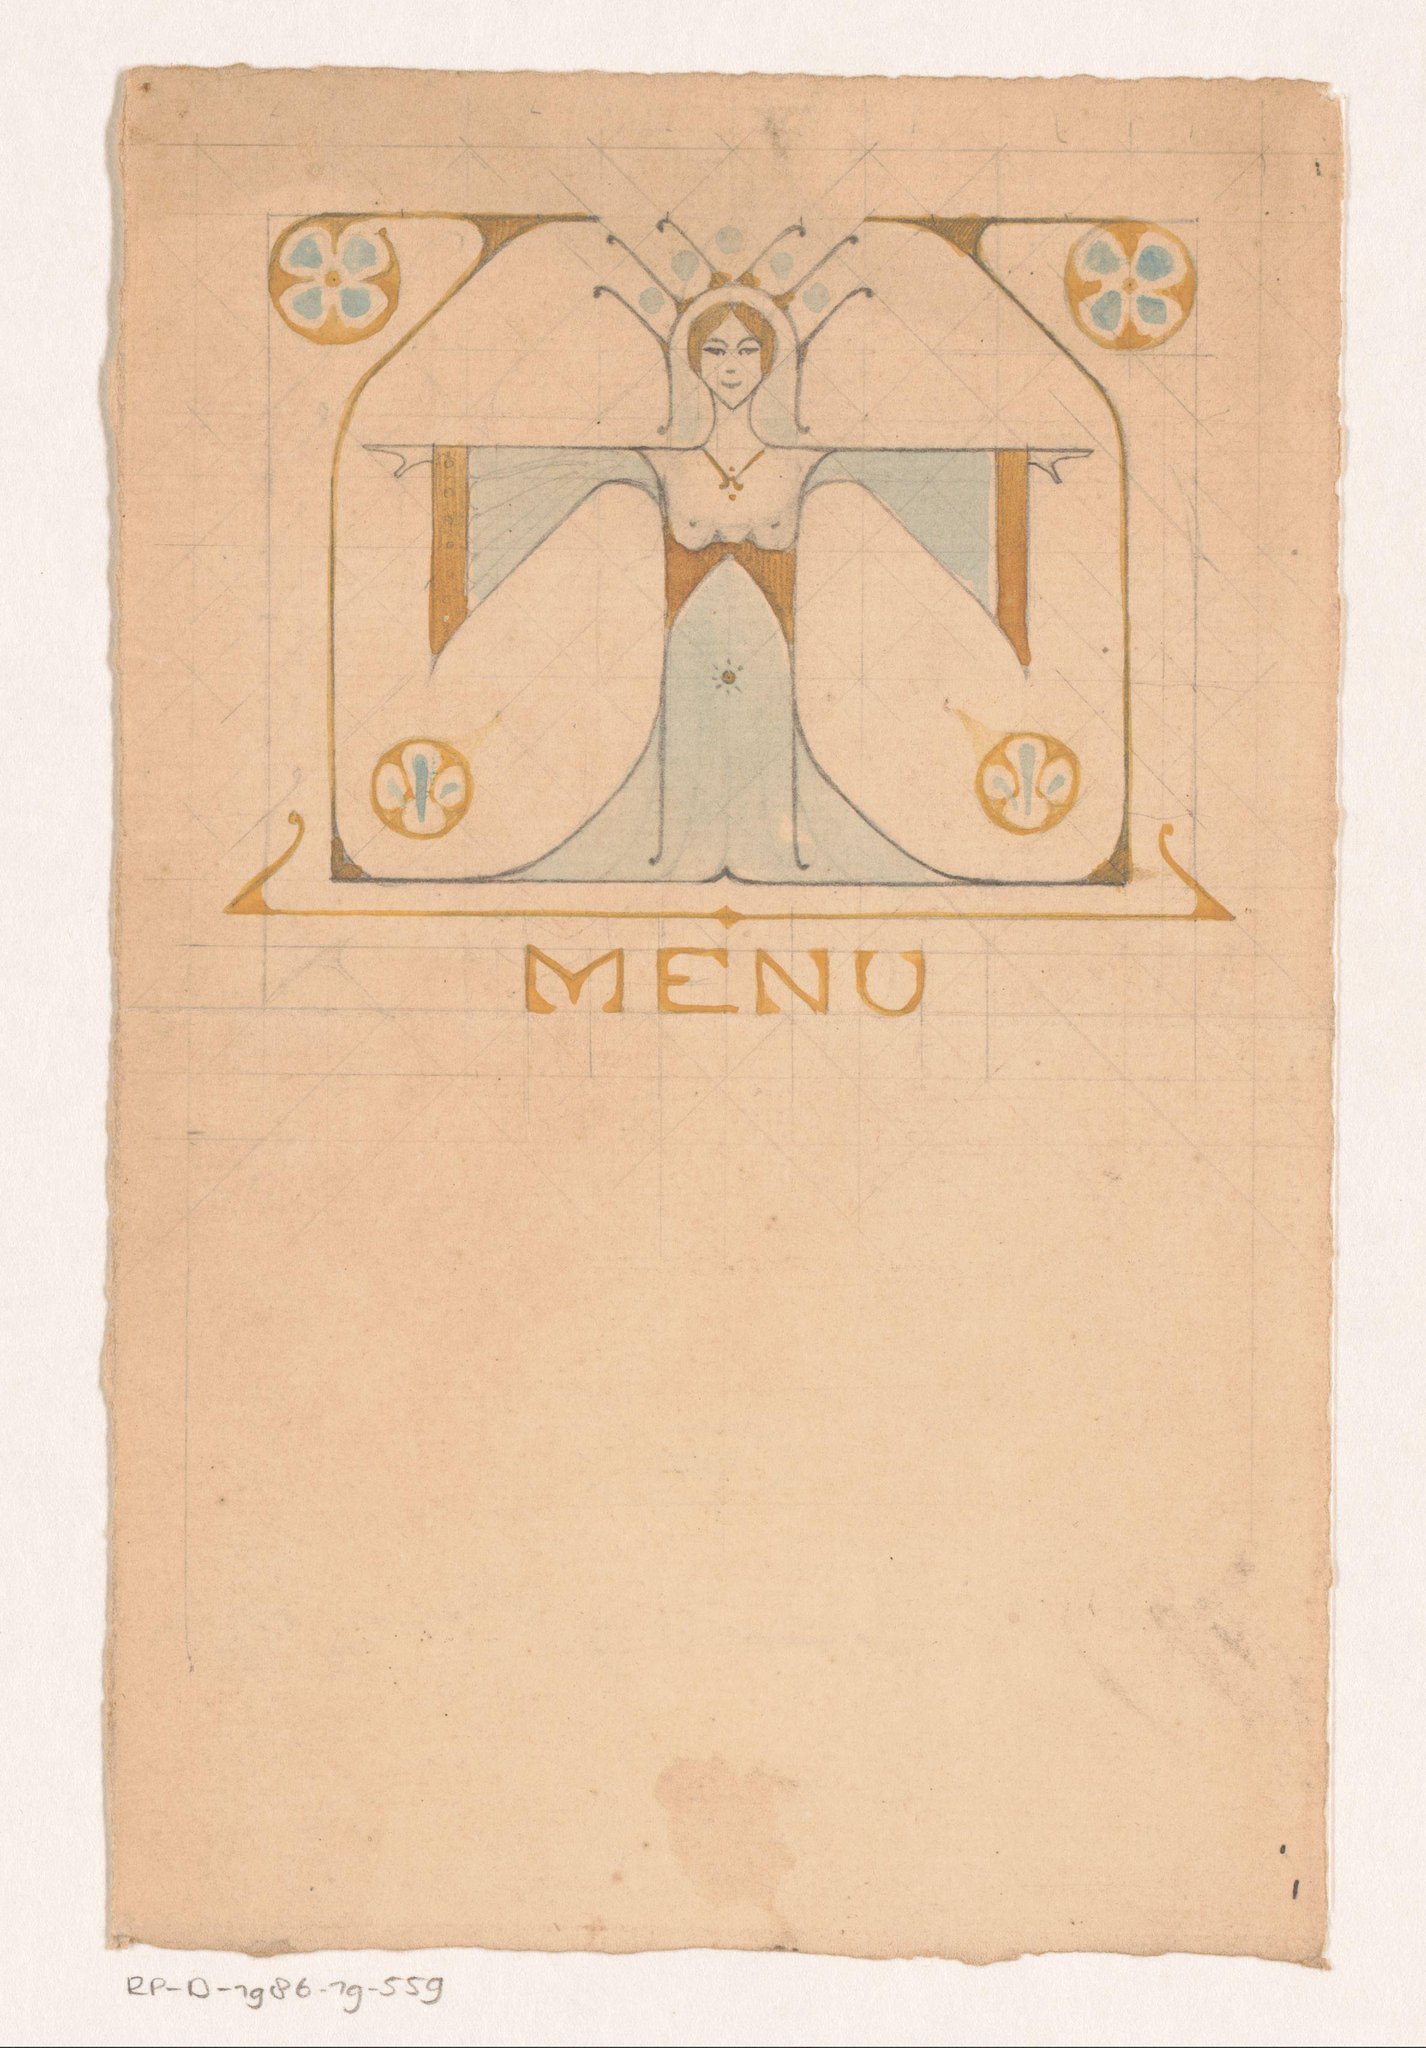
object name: drawing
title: Ontwerp voor een menukaart met een halfnaakte vrouw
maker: reinier willem petrus de vries (1874-1953)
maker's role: draughtsman, print maker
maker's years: 1874-1953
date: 1884-1952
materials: paper, pencil, watercolor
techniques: brush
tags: partially clothed, arm stretched sidewards - aa - both arms or hands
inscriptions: collector's mark: ‘R:MVS.’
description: De vrouw strekt haar armen uit naast haar lichaam.